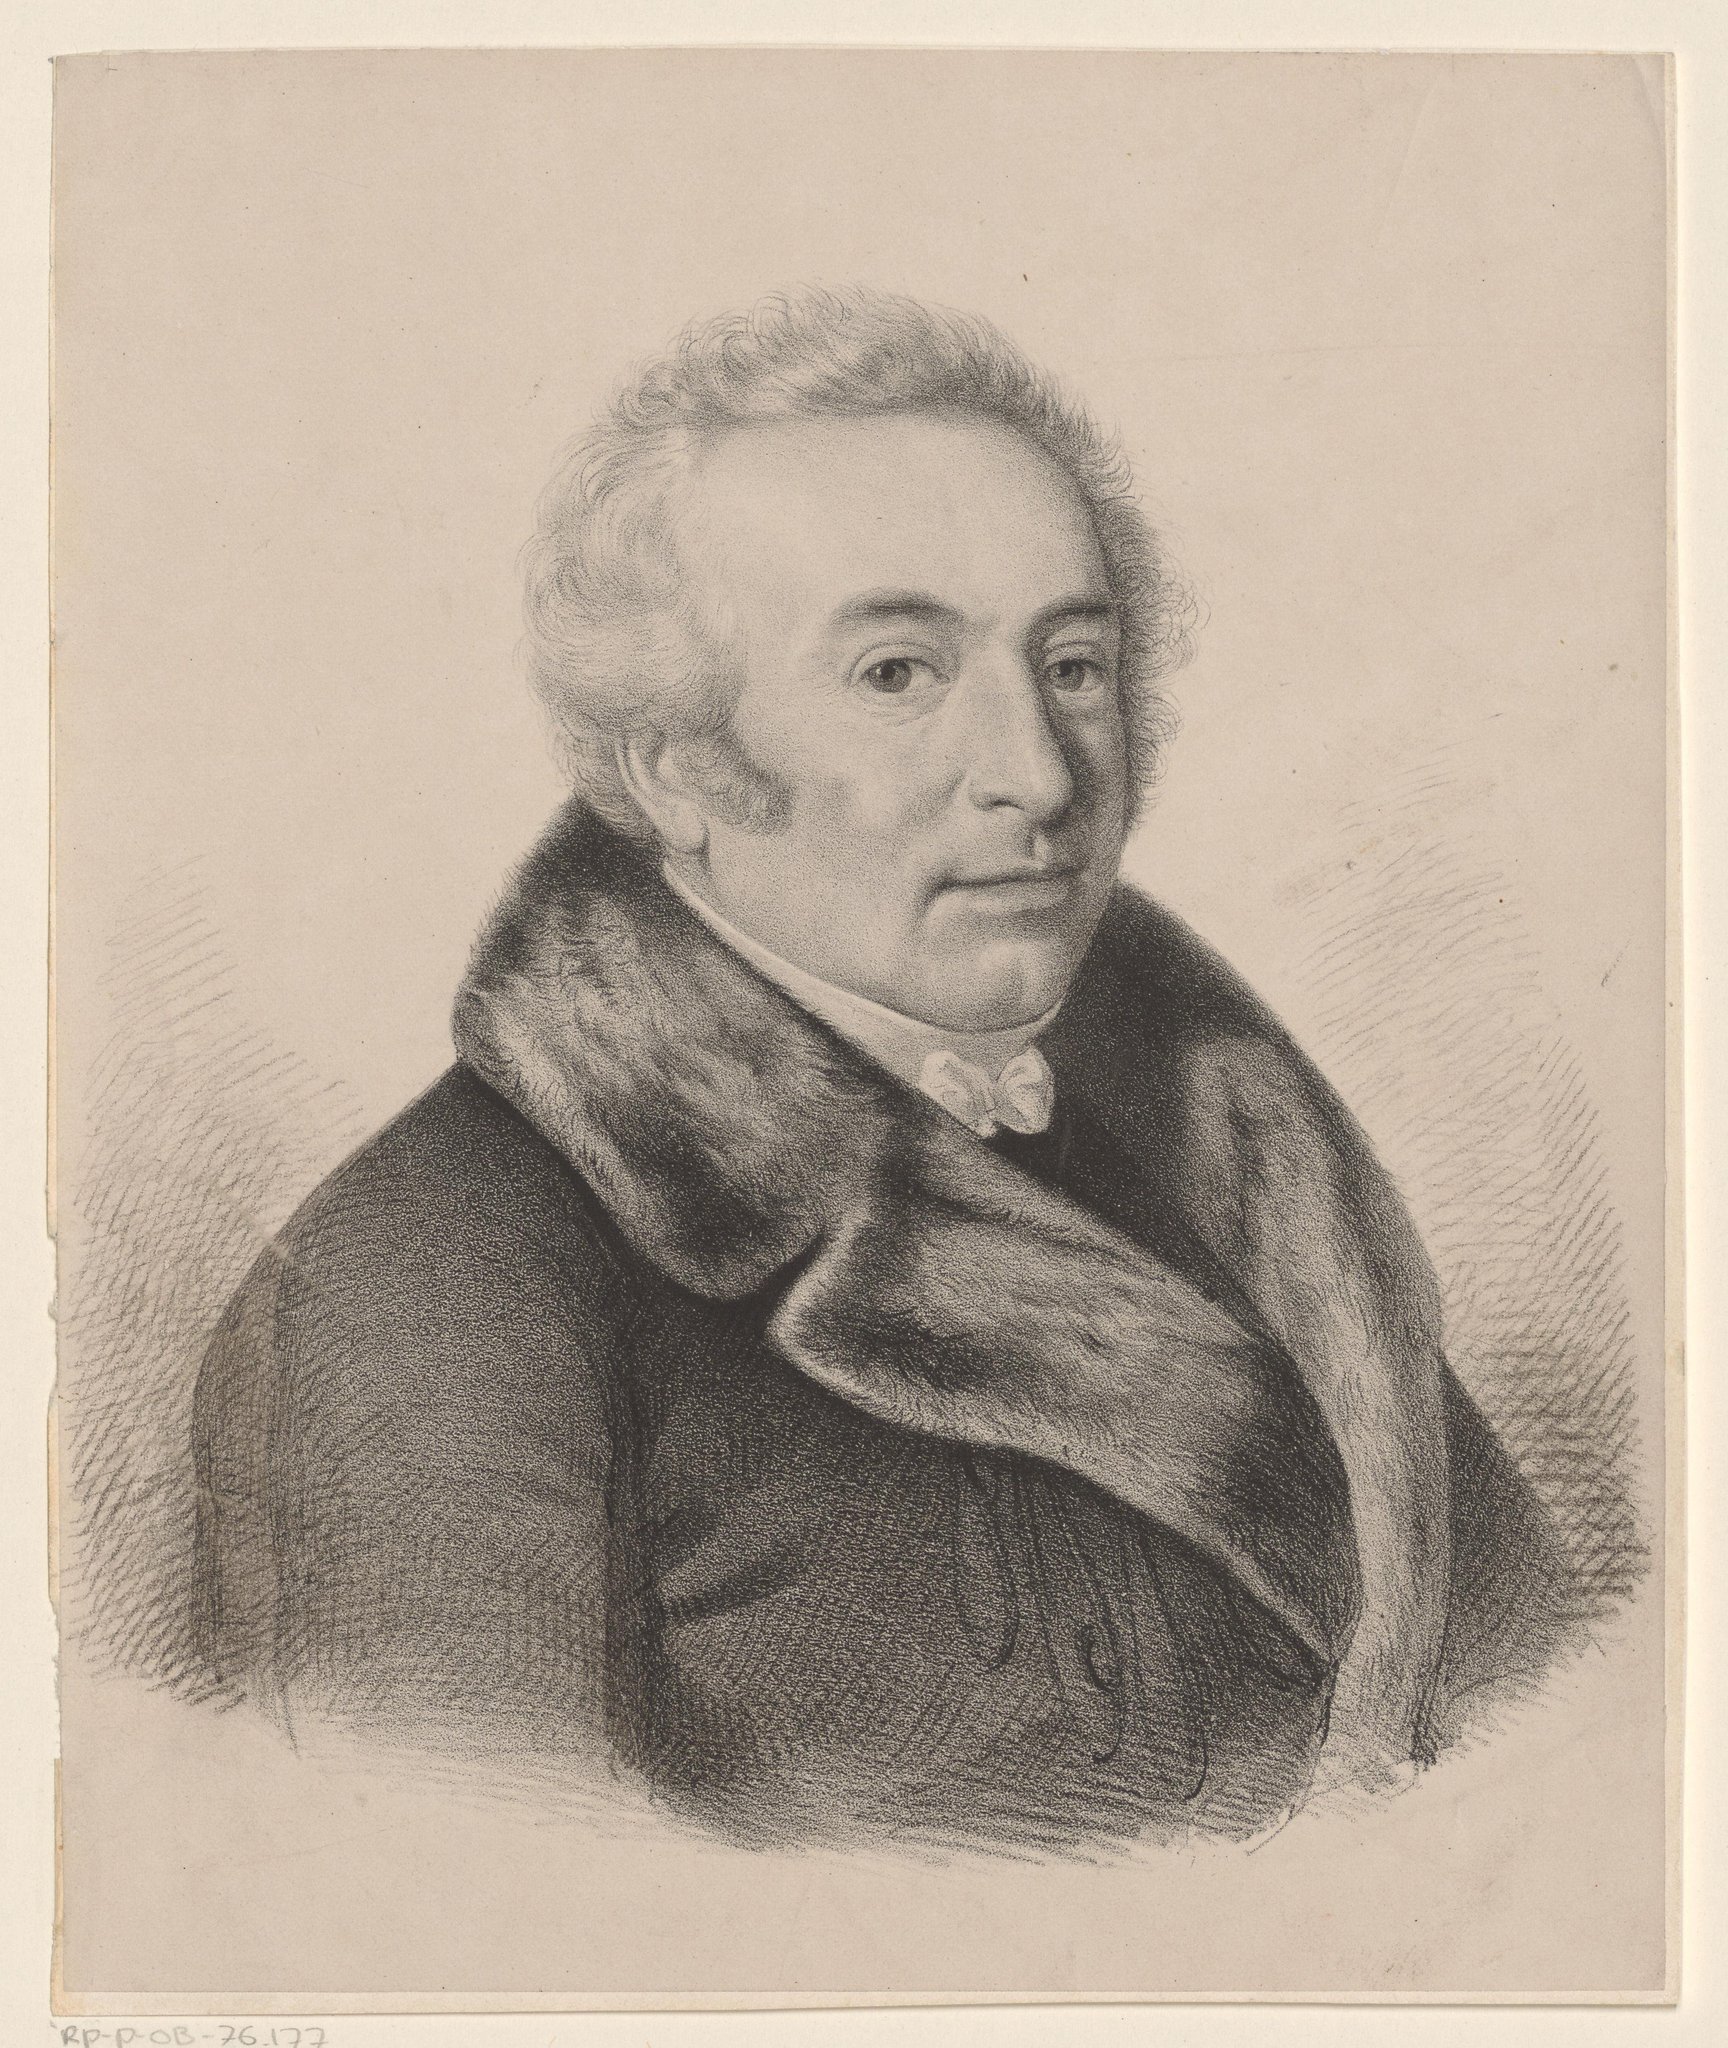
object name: print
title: Portret van Johannes Adriaans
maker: Anonymous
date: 1820-1899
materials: paper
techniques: lithograph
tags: johannes adriaans